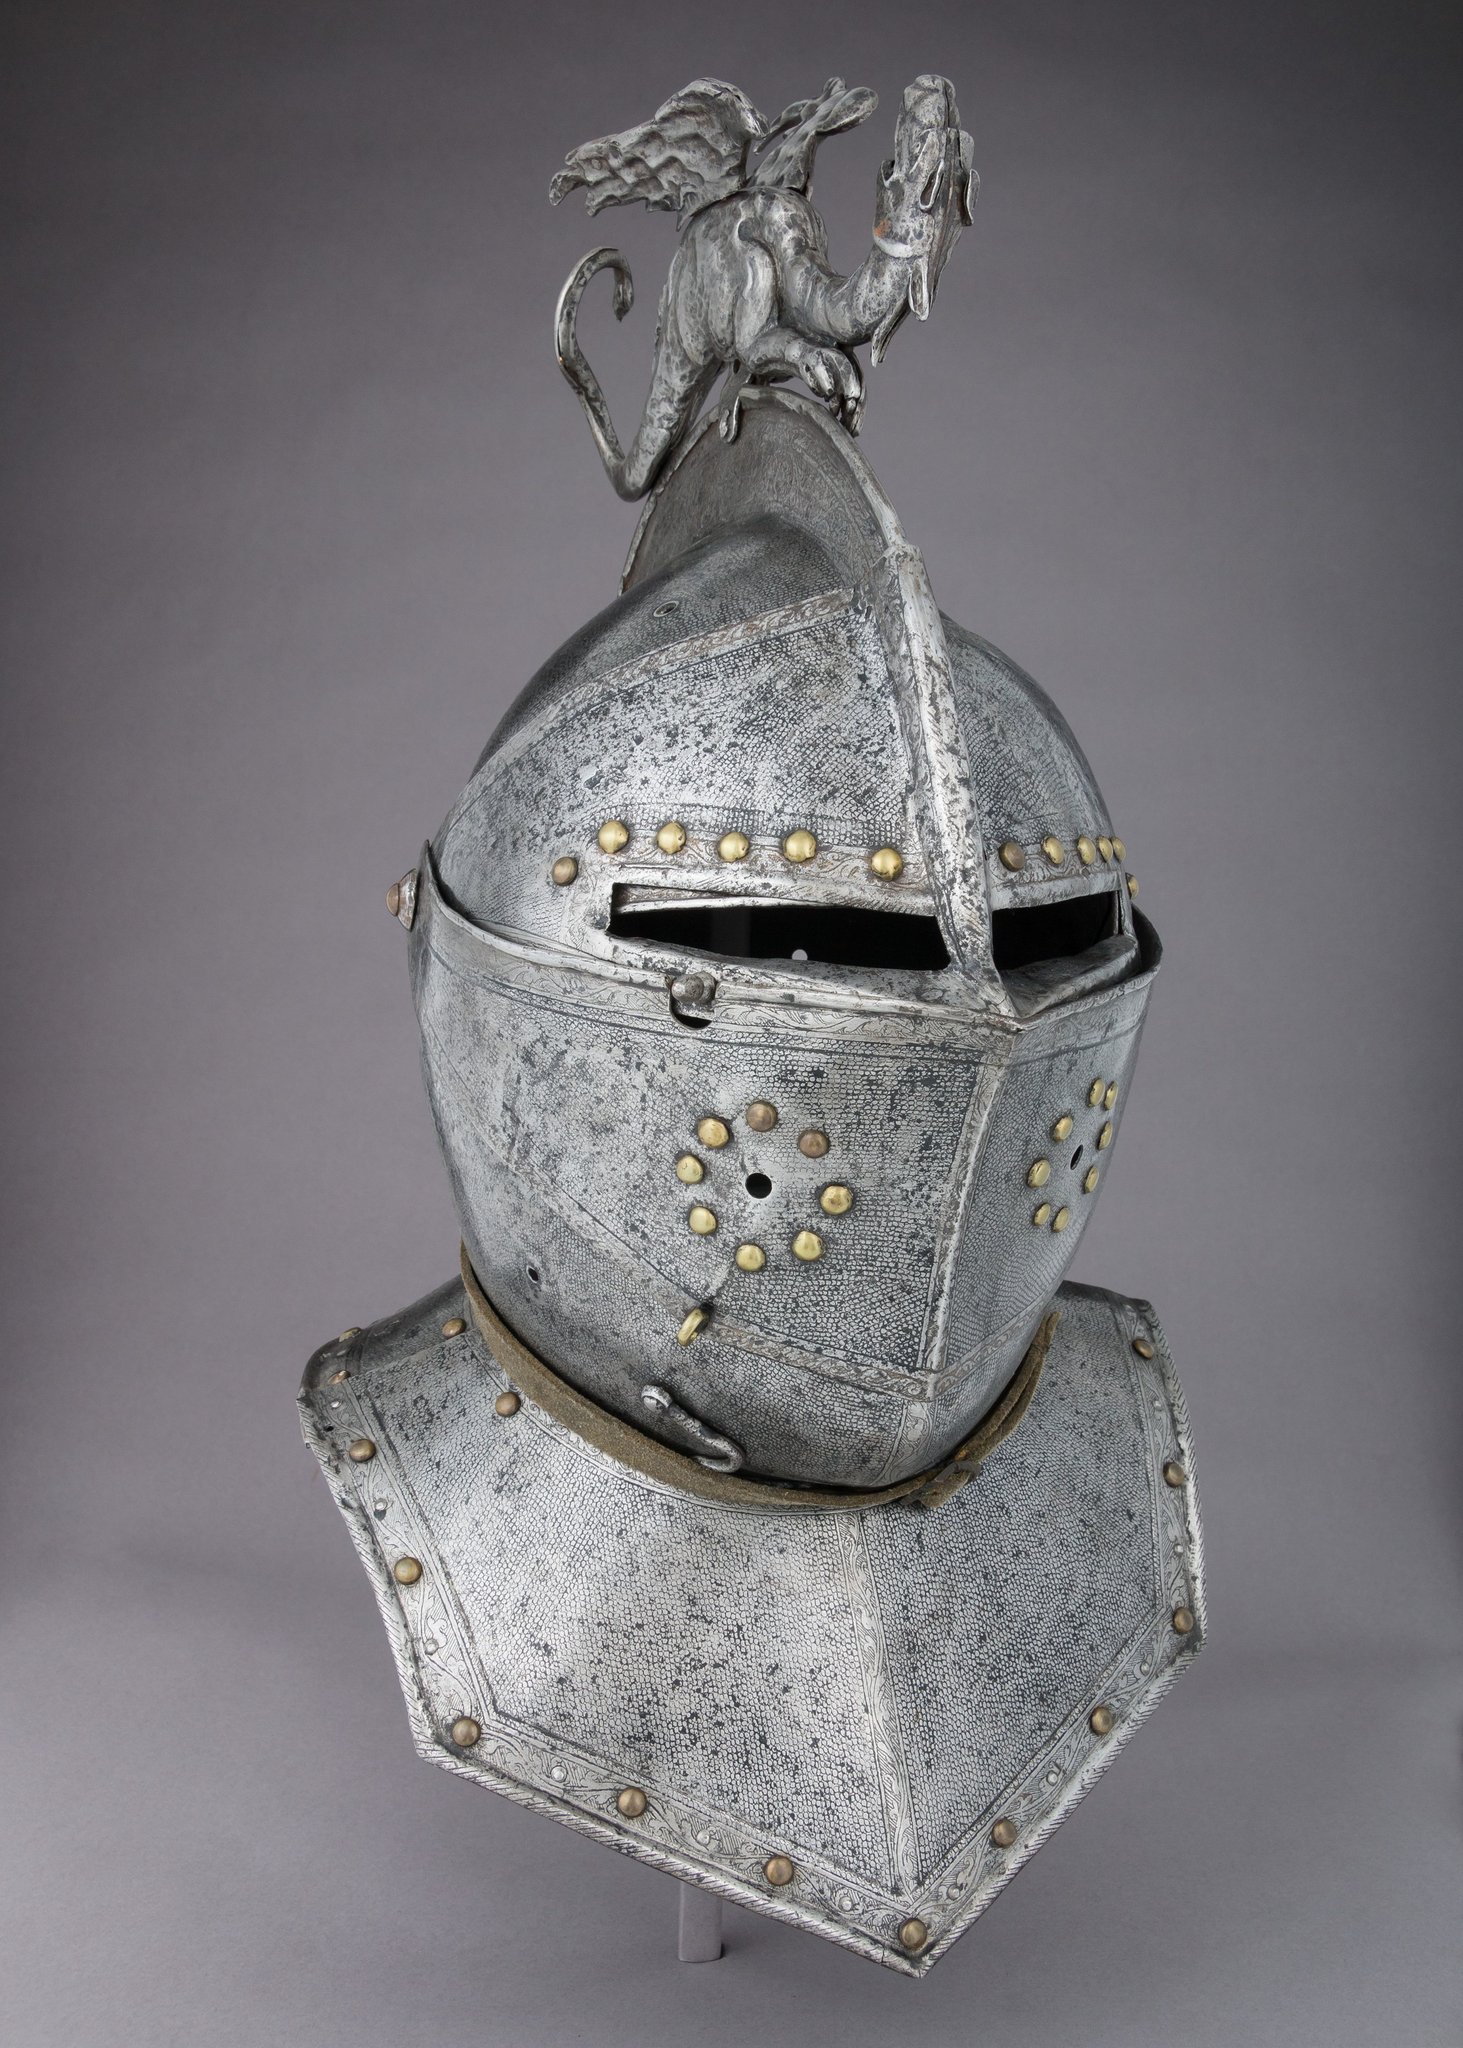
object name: close helmet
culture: french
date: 1630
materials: brass, gold, steel, iron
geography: france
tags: dragons